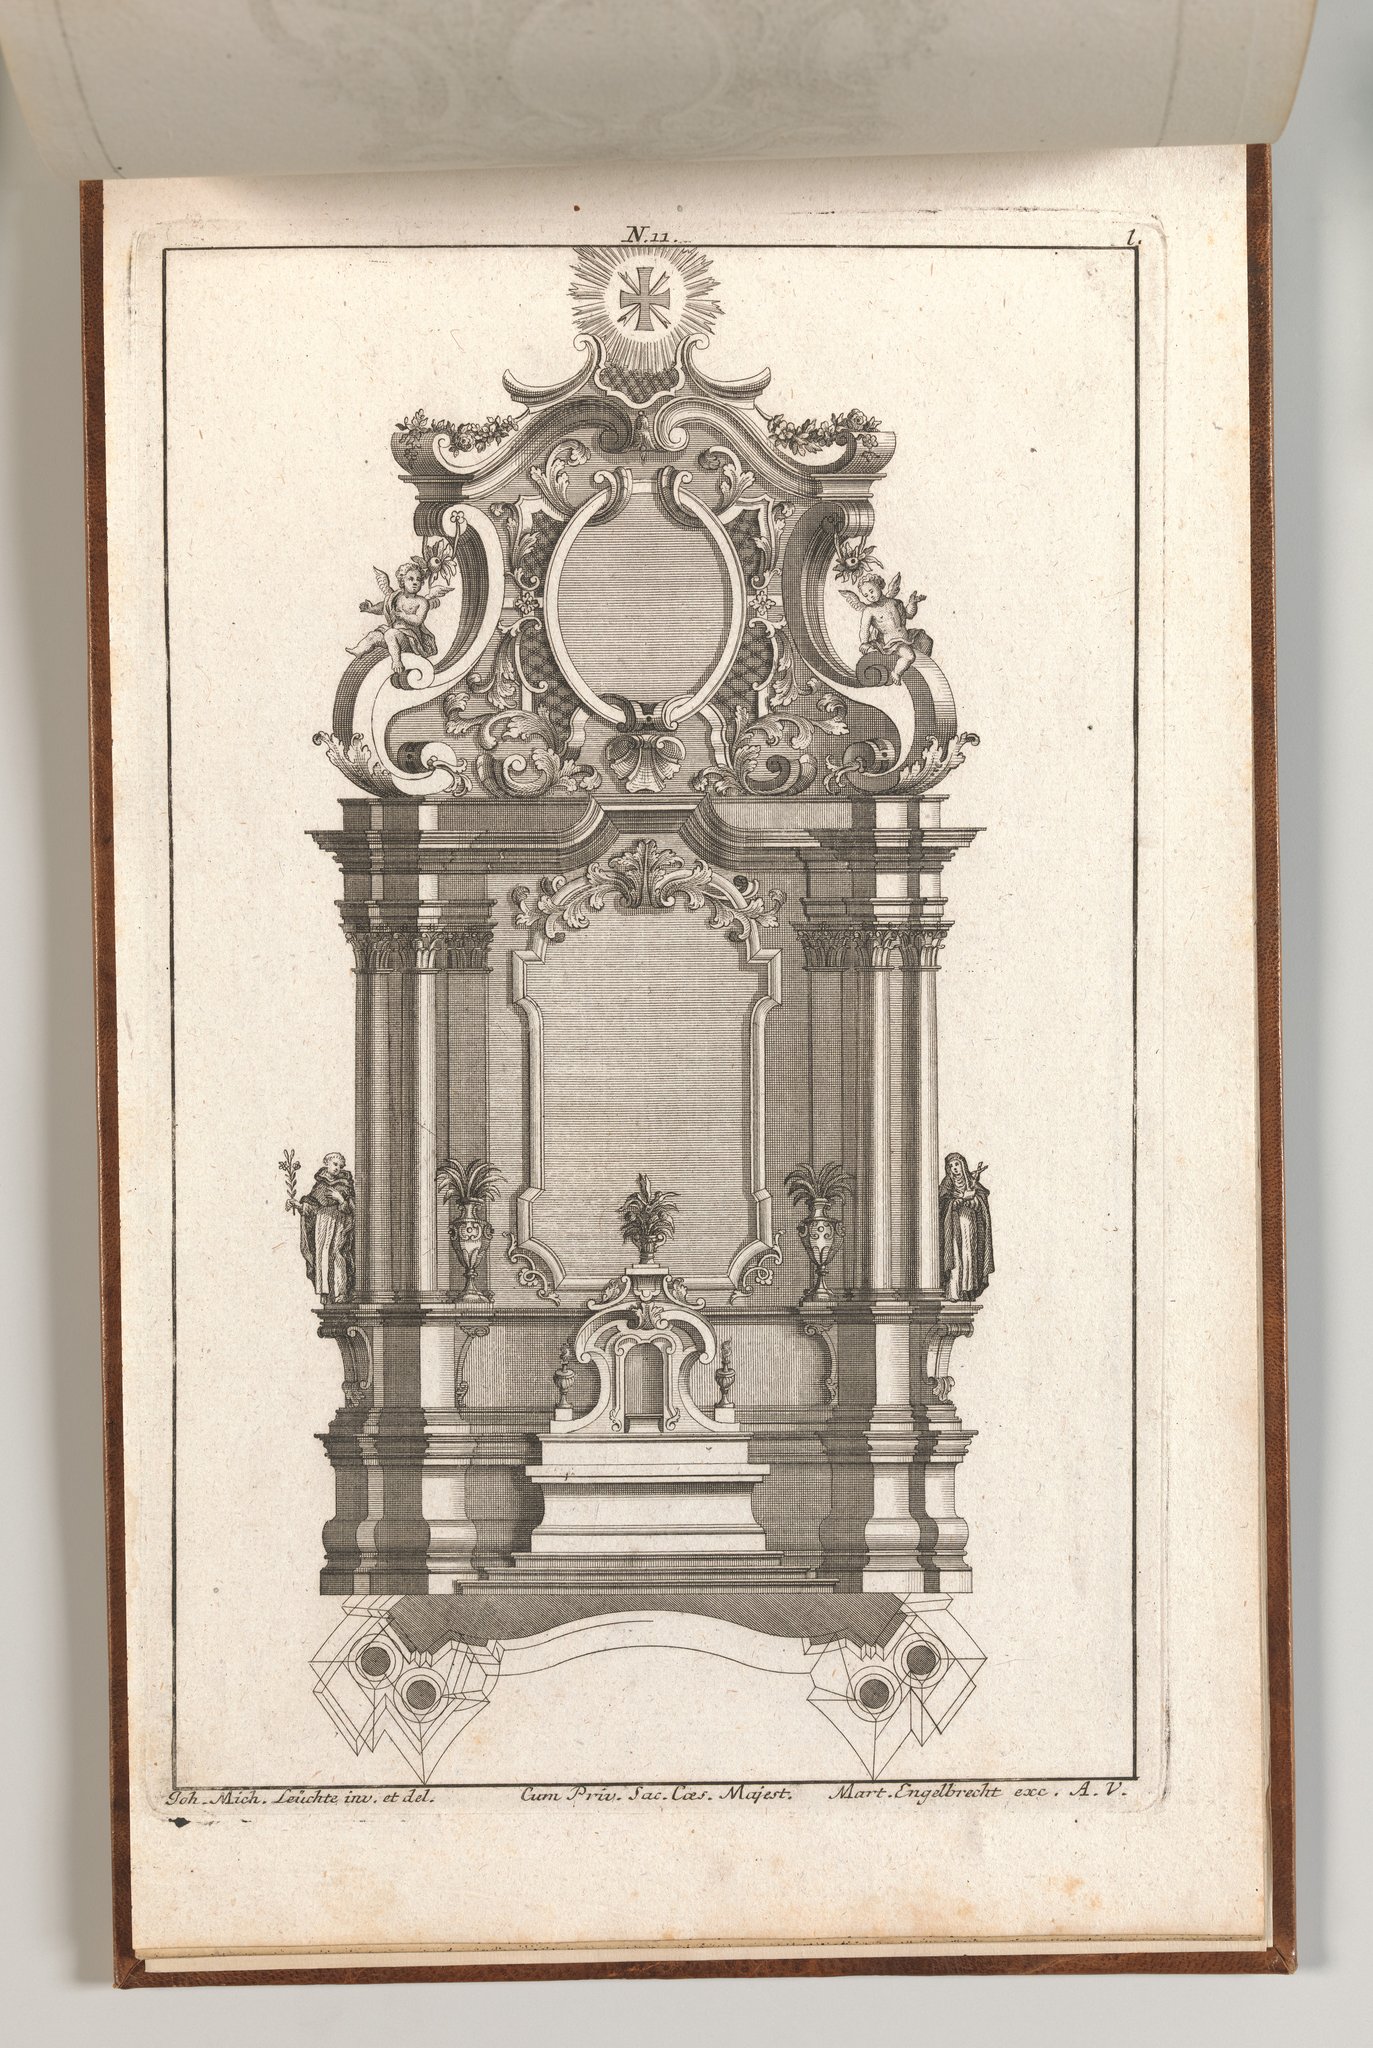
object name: album print ornament architecture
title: Design for a Monumental Altar, Plate L from 'Unterschiedliche Neu Inventierte Altäre mit darzu gehörigen Profillen u. Grundrißen.'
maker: johann michael leüchte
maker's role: artist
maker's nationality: german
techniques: etching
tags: human figures,altars,angels